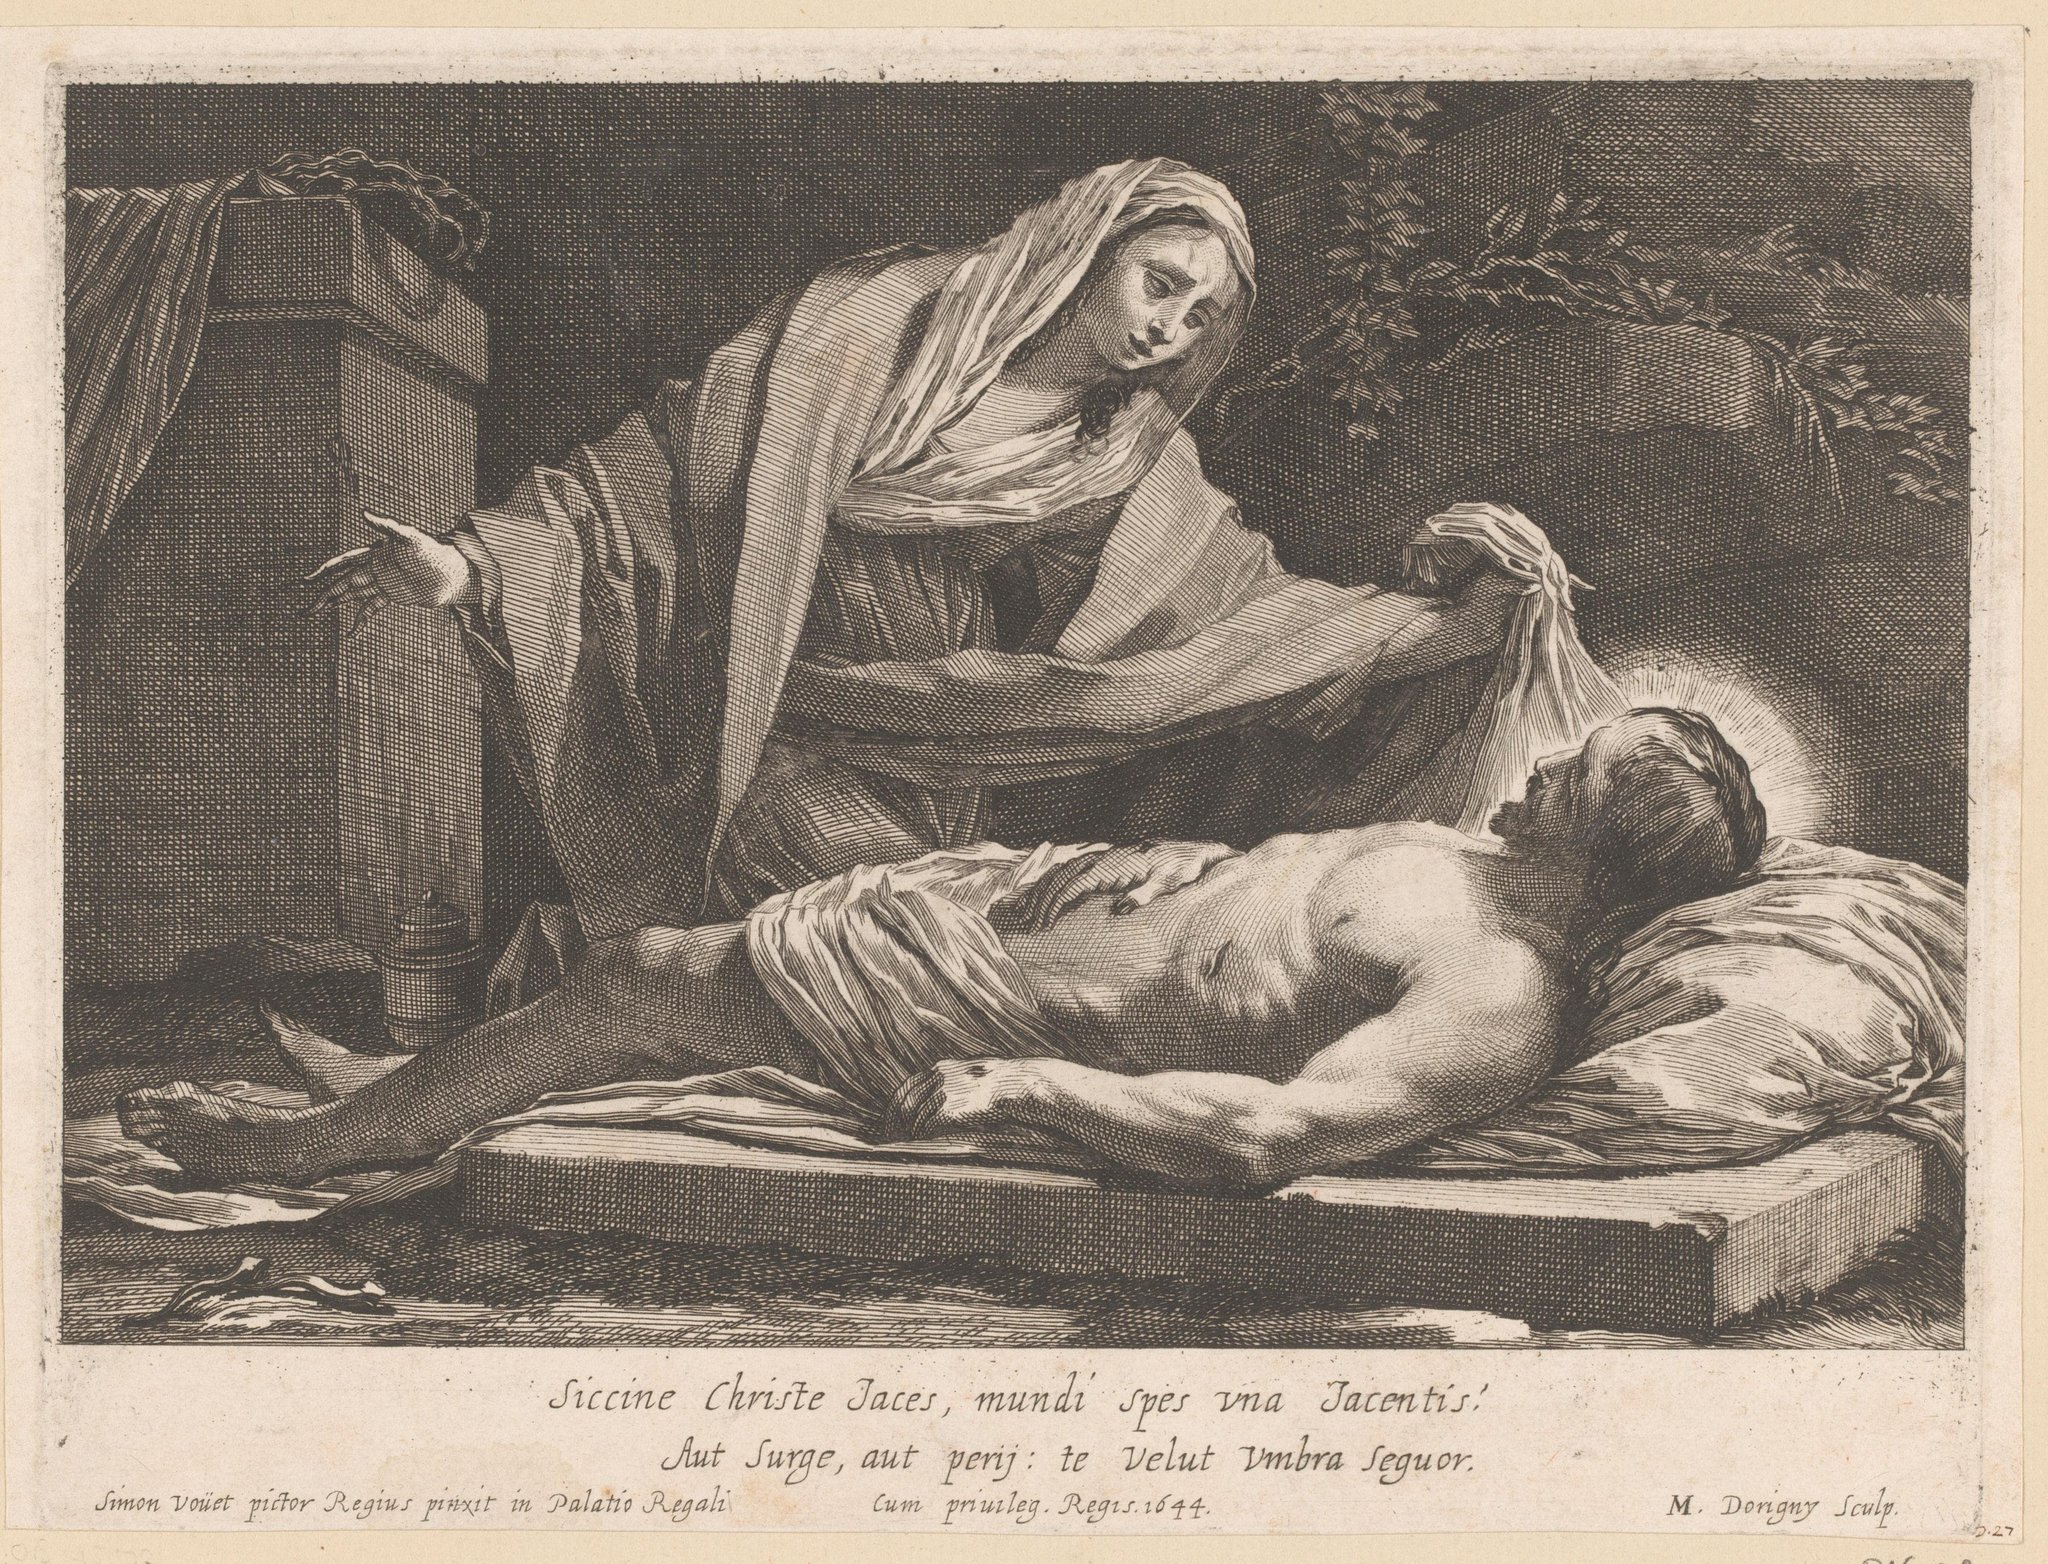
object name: print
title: Graflegging van Christus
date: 1644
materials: paper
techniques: engraving, etching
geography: france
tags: christ's entombment (possibly by angels), the penitent harlot mary magdalene; possible attributes: book (or scroll), crown, crown of thorns, crucifix, jar of ointment, mirror, musical instrument, palm-branch, rosary, scourge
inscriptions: collector's mark: Lugt 240